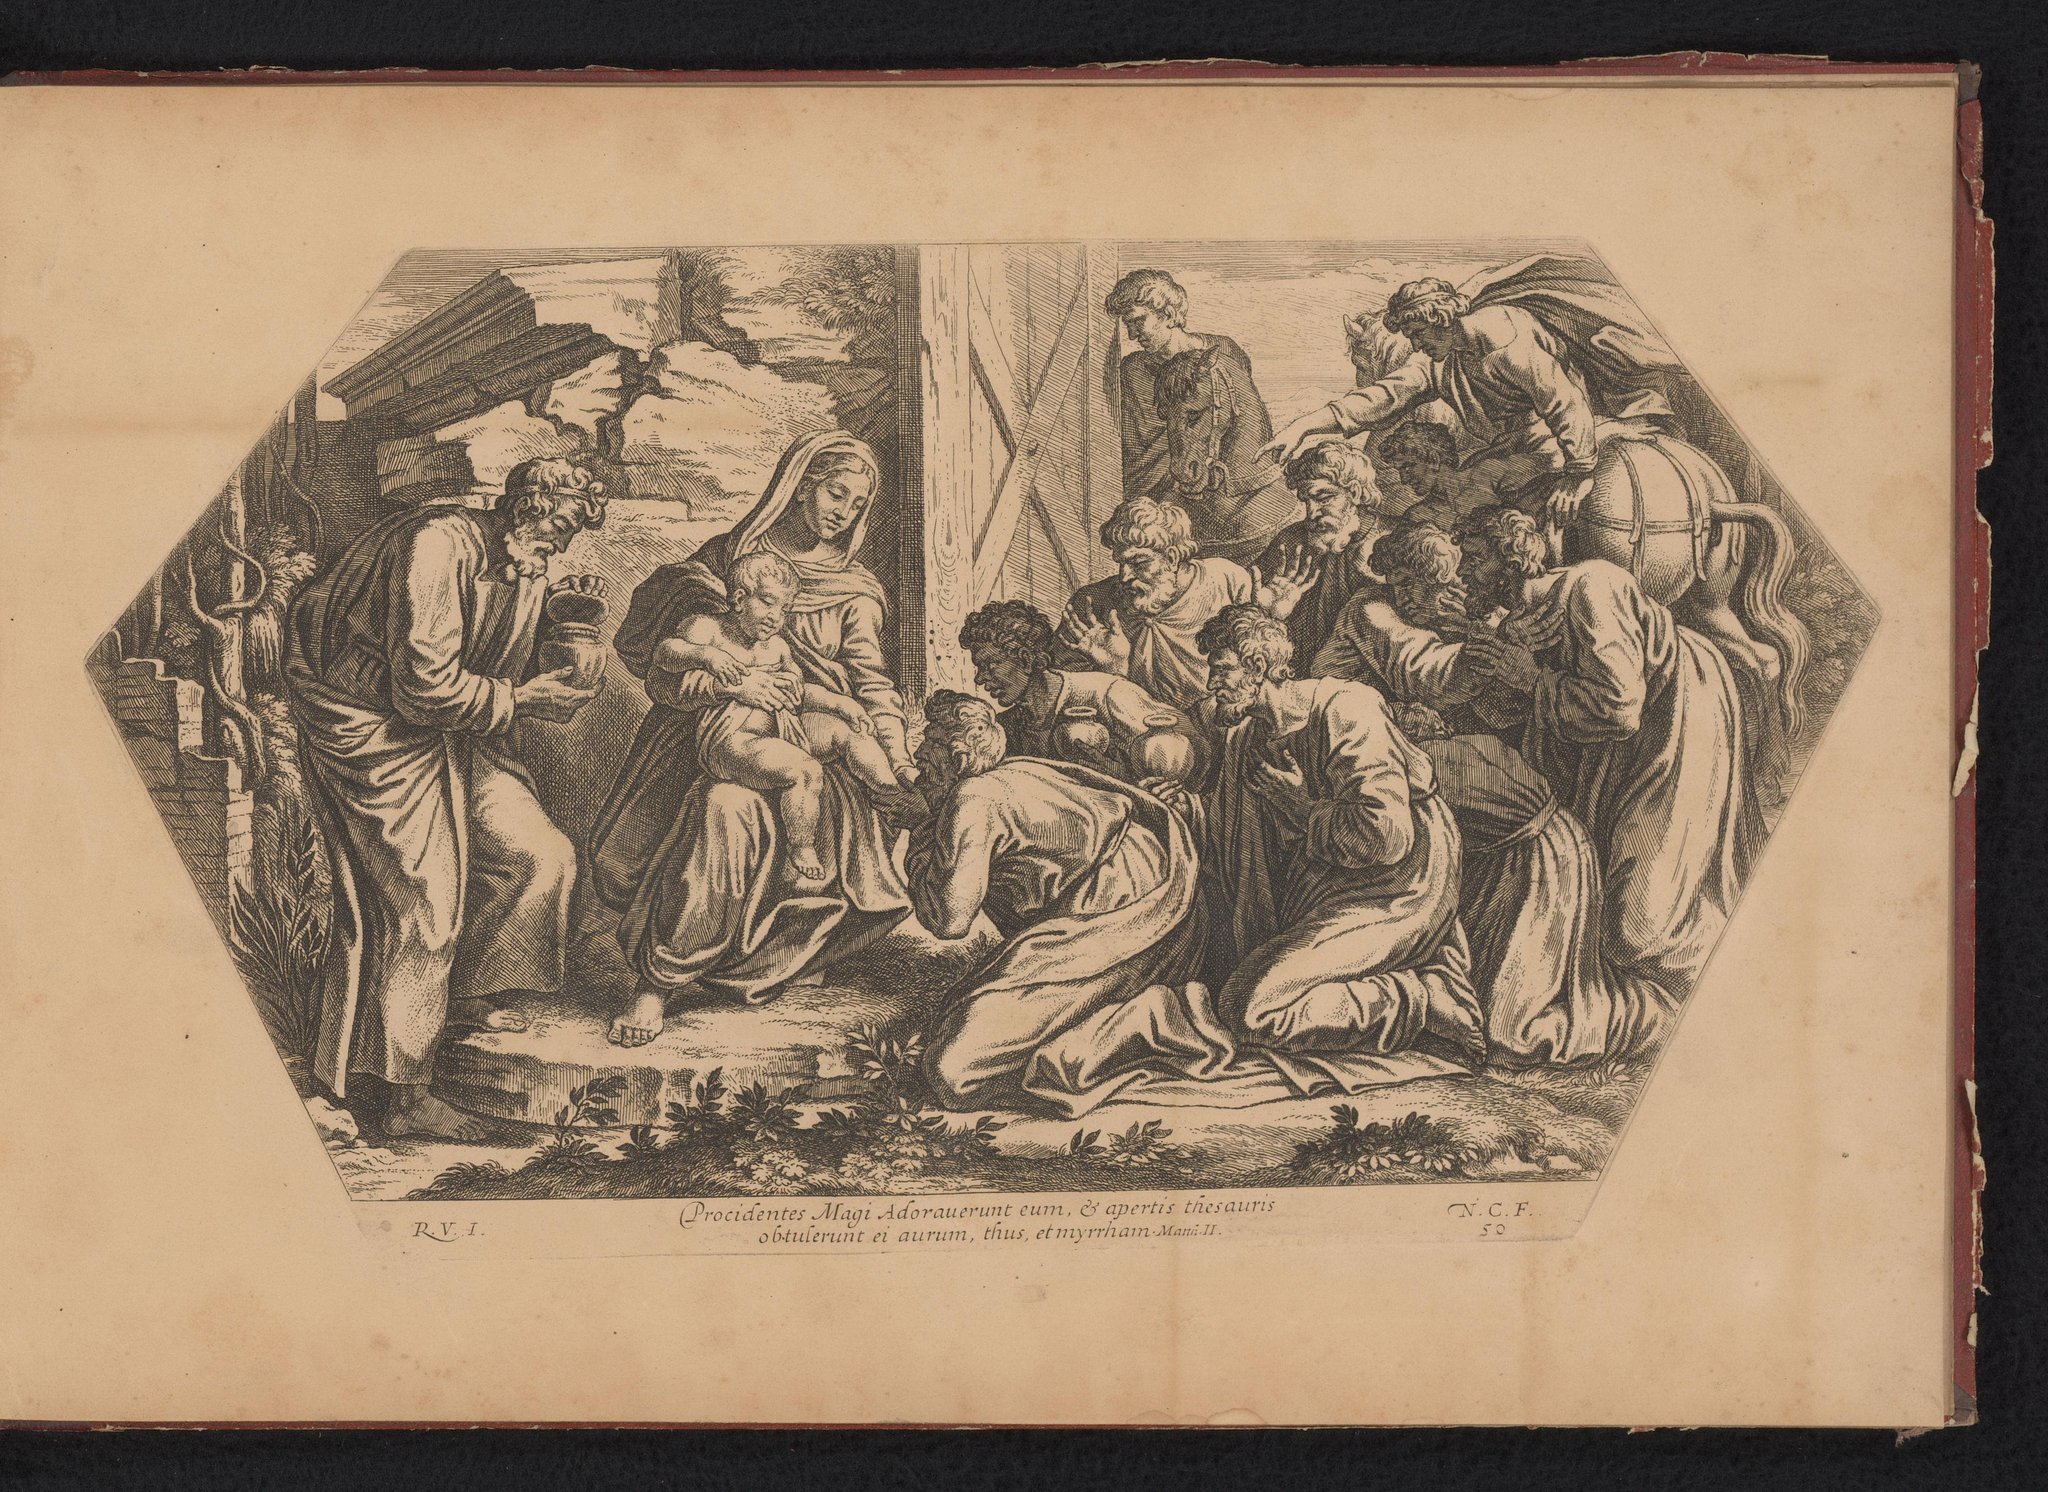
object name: album leaf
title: Sacrae historiae acta a Raphael Urbin in Vaticanis xystis ad picturae miraculum expressa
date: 1649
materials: paper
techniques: etching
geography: paris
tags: adoration of the kings: the wise men present their gifts to the christ-child (gold, frankincense and myrrh) (+ donor(s), supplicant(s), whether or not with patron saint(s))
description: Deze prent maakt deel uit van een album.